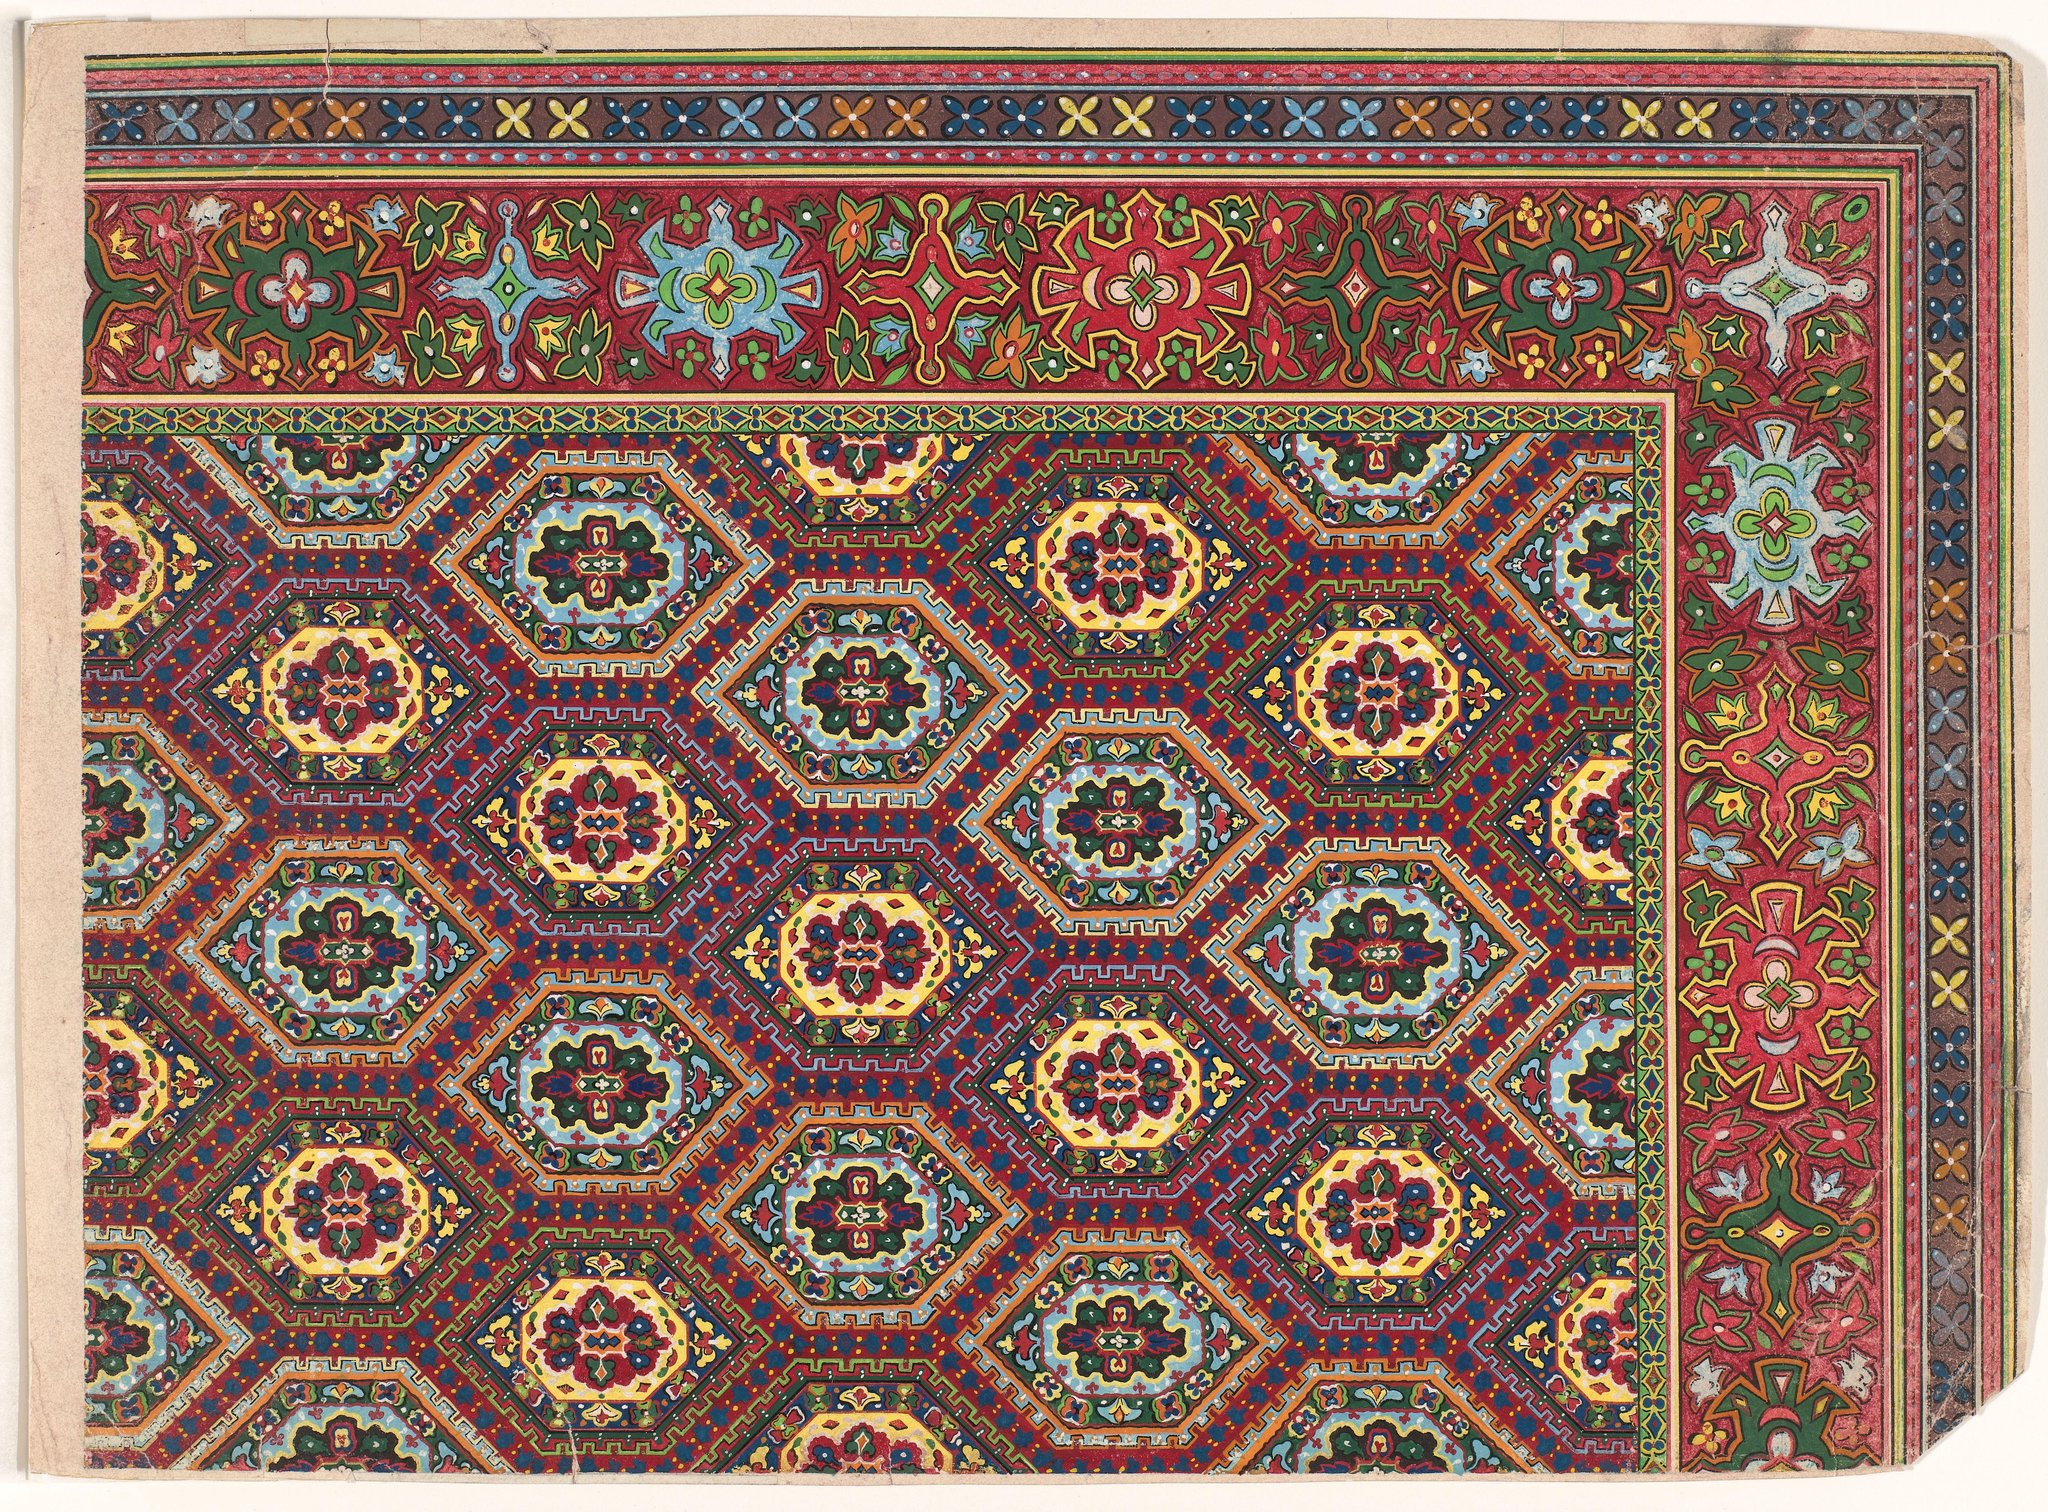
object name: drawing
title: Ontwerp voor een tapijt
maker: Anonymous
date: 1854-1864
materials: gouache, paper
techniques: brush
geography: deventer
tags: ornaments ~ art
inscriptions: retailer's mark: ‘JHS.’, inscription: ‘F’, number: ‘No 2.’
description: De presentatietekeningen BK-1971-77-1 t/m 86 zijn kopieën van de originele ontwerptekeningen. Ze werden gemaakt voor vertegenwoordigers van bijvoorbeeld magazijnen, die ze aan hun klanten konden tonen. De meeste tekeningen tonen een kwart van het dessin inclusief rand, middenpartij (de zogenaamde grond of fond) en centraal medaillon. Door het gebruik van spiegels kan de illusie van het gehele tapijt worden opgeroepen. Een deel van de tekeningen heeft een alfabetische opeenvolgende letter als kenmerk, de andere groep een cijfer.Waarschijnlijk is de reeks dessins met een letter eerder samengesteld dan de genummerde tekeningen.